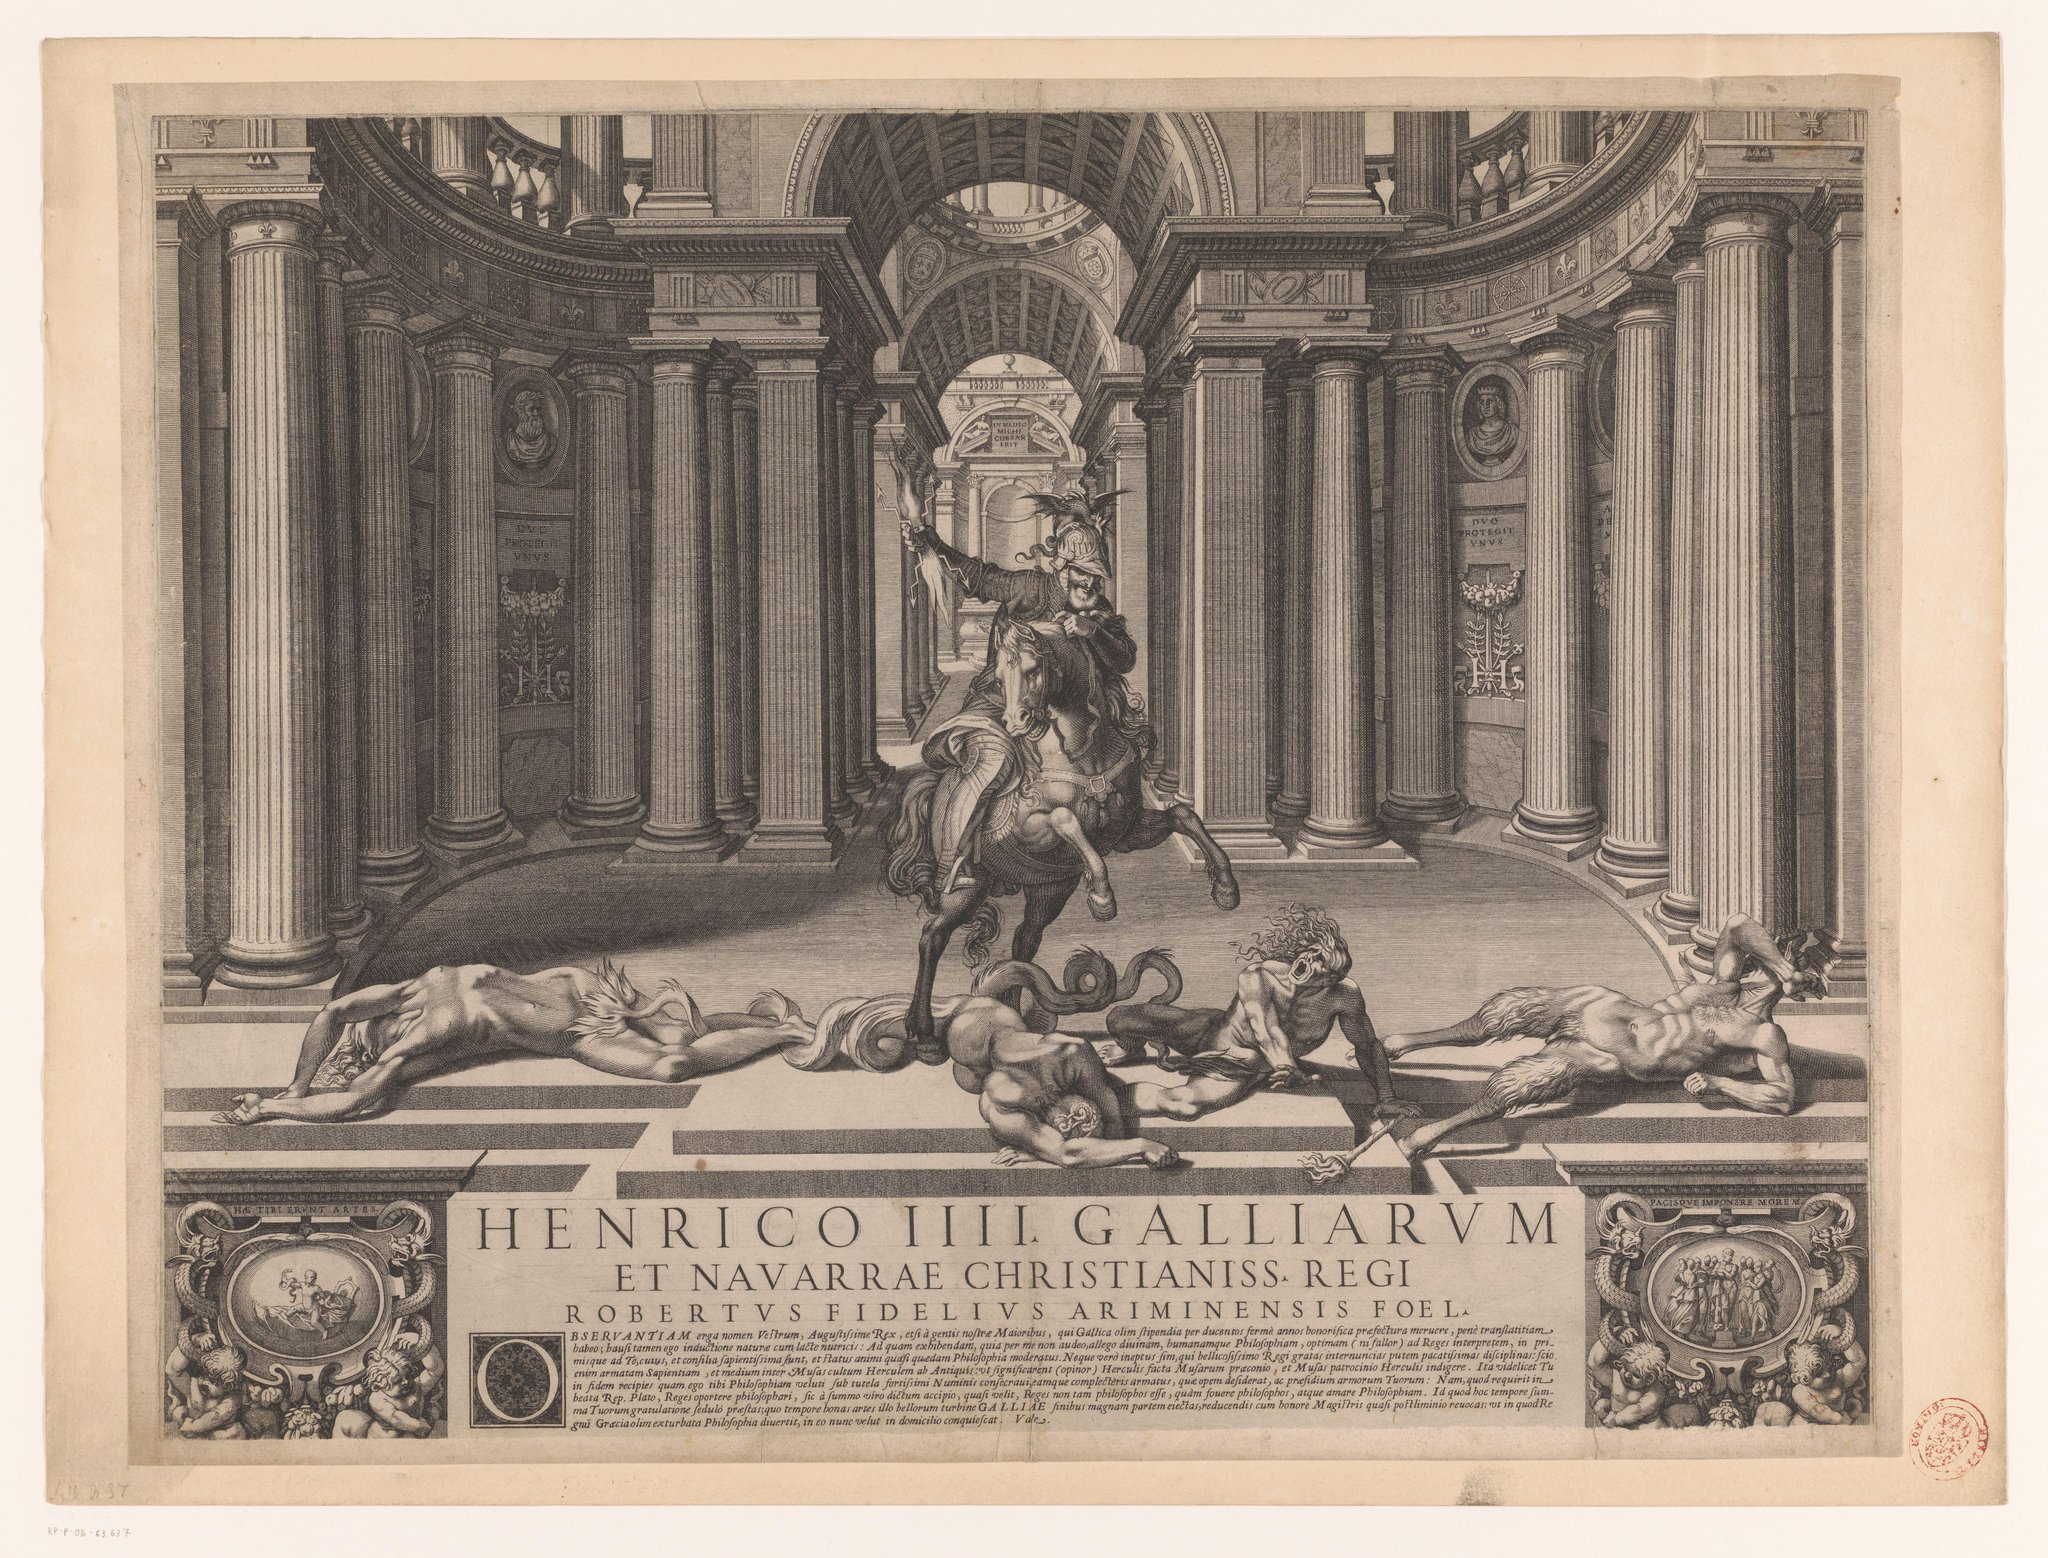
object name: print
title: Hendrik IV van Frankrijk te paard als overwinnaar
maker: Anonymous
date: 1572-1650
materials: paper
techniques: engraving, etching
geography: france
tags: paris, hendrik iv (koning van frankrijk en navarra), riding a horse, ass, or mule; rider, horseman, historical persons, king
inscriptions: collector's mark: Lugt 240